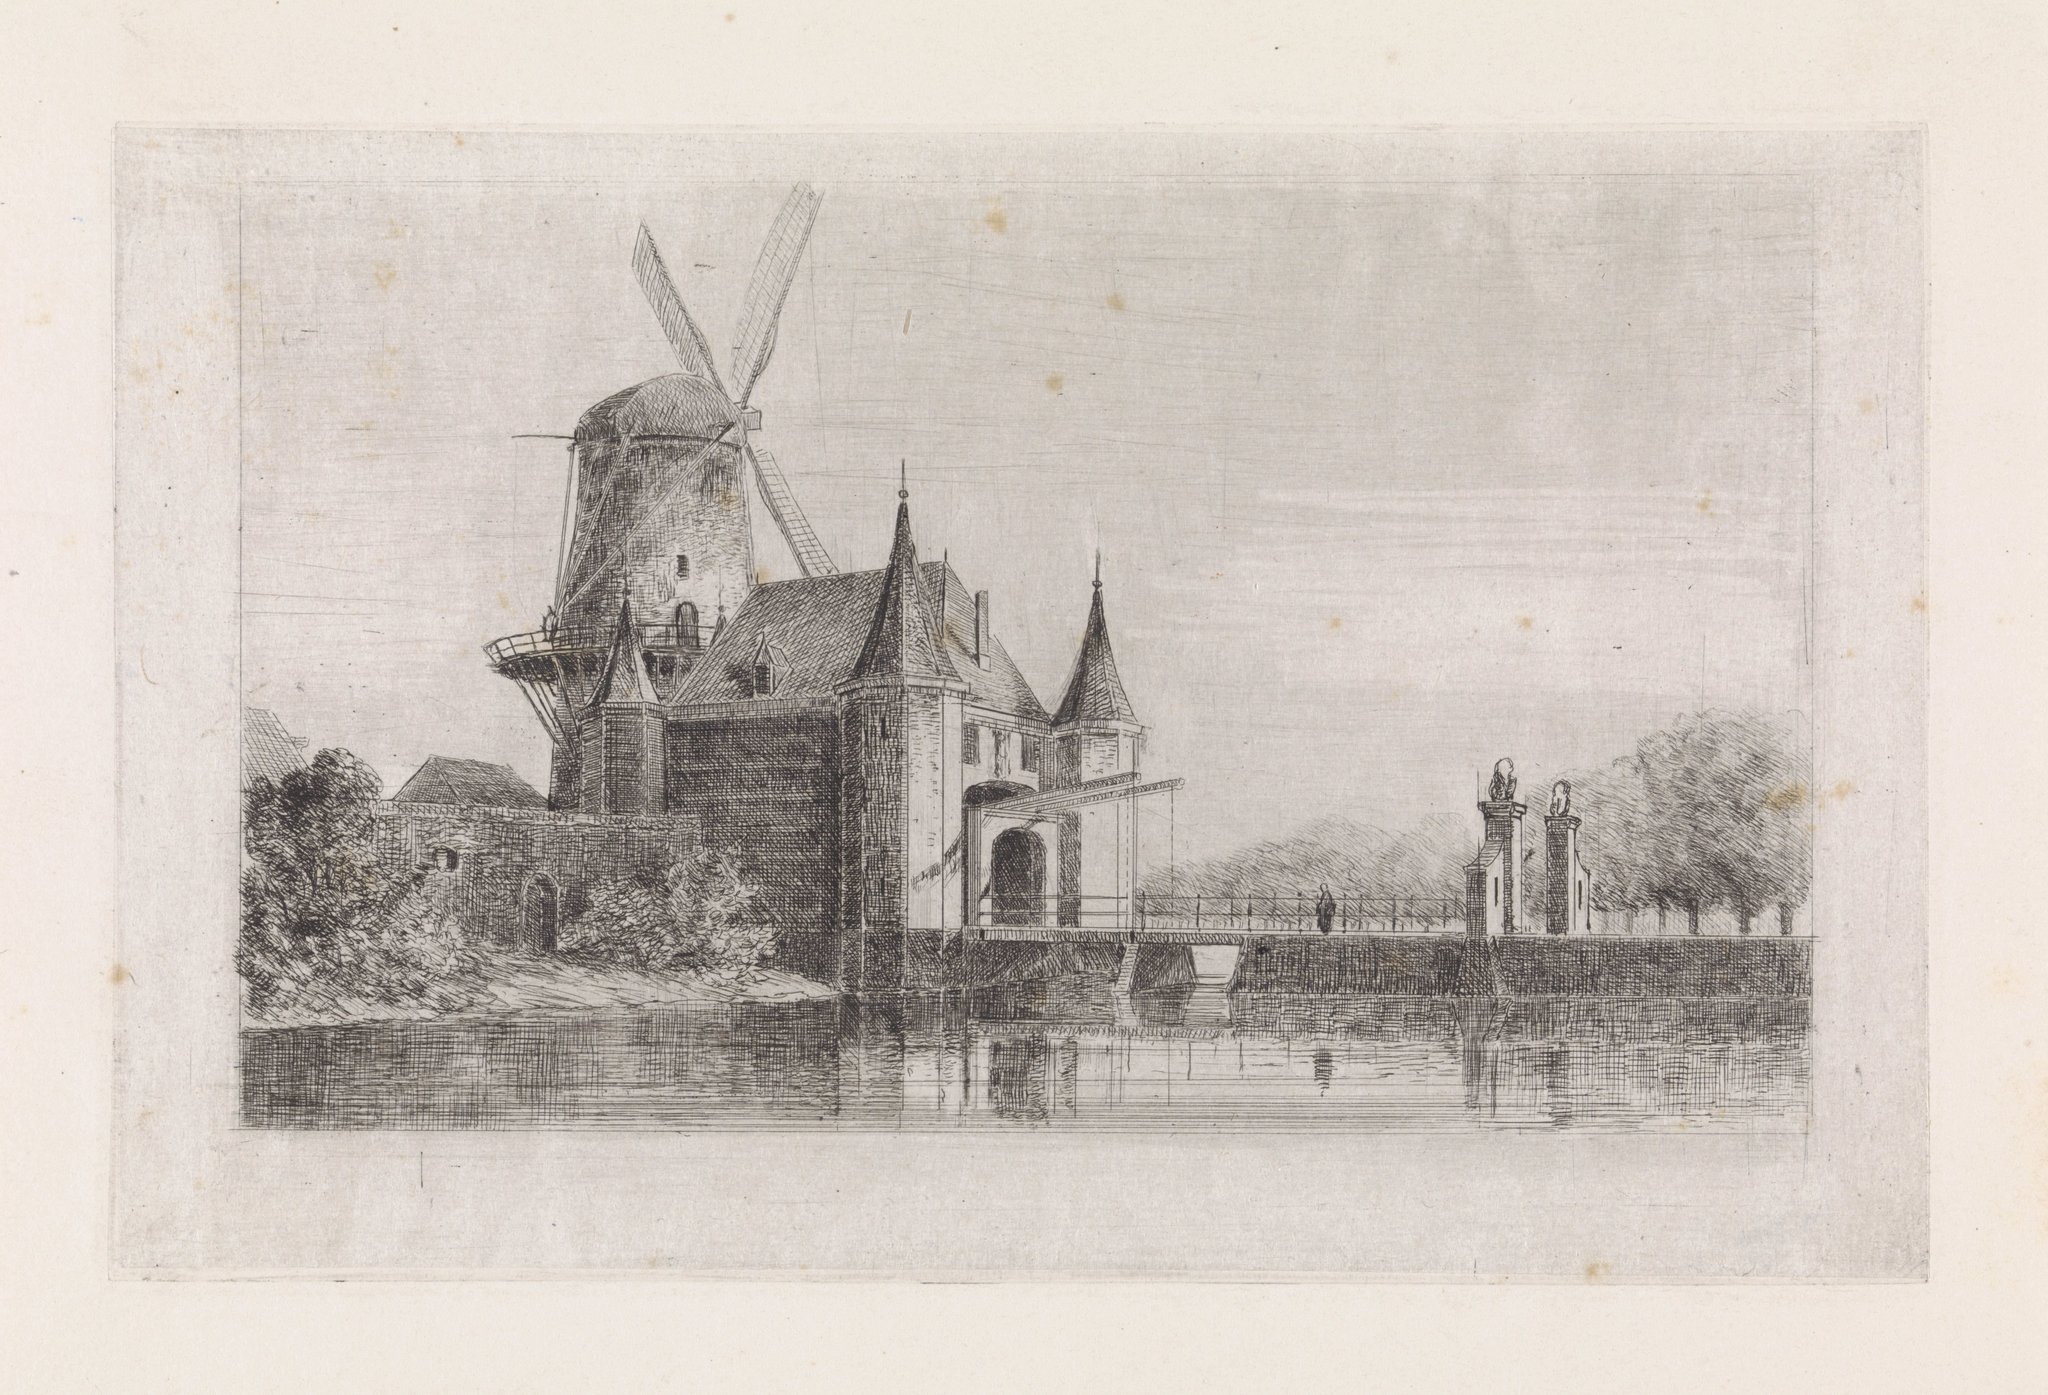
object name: print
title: Kleiwegpoort te Gouda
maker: gijsbertus johannes verspuy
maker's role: print maker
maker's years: 1823-1862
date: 1833-1862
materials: paper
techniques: etching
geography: netherlands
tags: river, windmill, city-gate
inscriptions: collector's mark: Lugt 2228, collector's mark: Lugt 1485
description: Gezicht op de Kleiwegpoort te Gouda met erachter een molen.